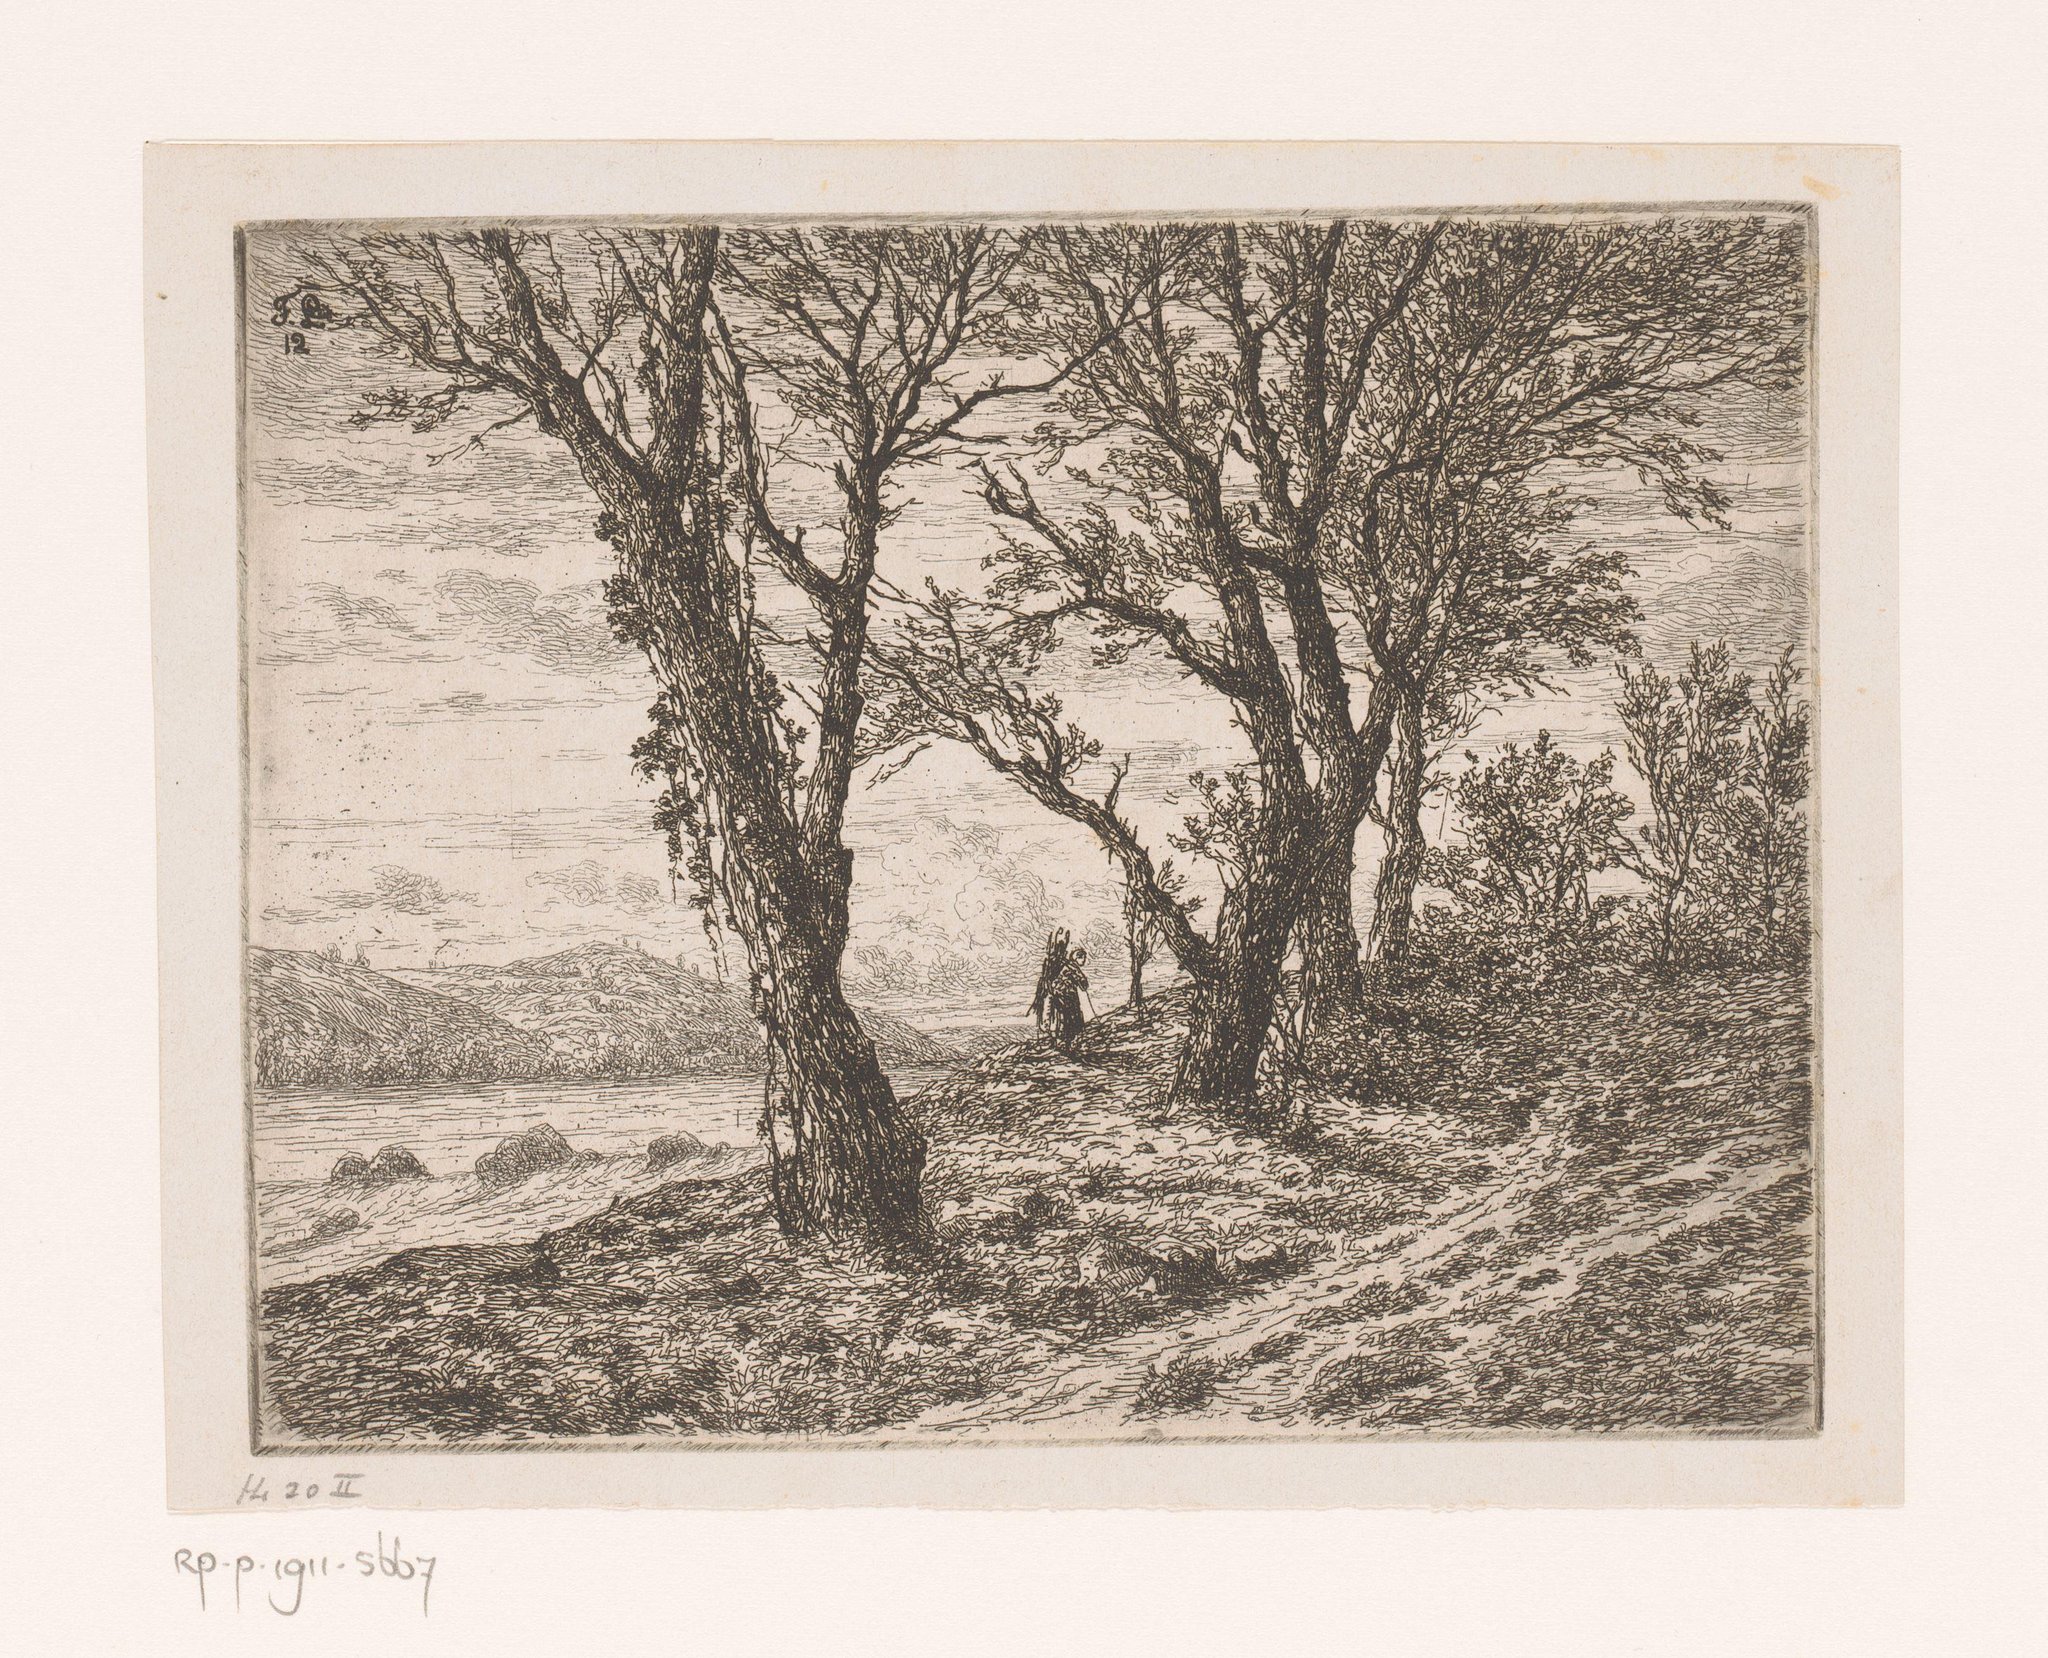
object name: print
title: Vrouw met takkenbos op haar rug onder hoge bomen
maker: jean pierre françois lamorinière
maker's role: print maker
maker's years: 1828-1911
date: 1838-1879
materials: paper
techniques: etching, intaglio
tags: carrying something, deciduous forest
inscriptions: collector's mark: Lugt 1485, collector's mark: Lugt 2228